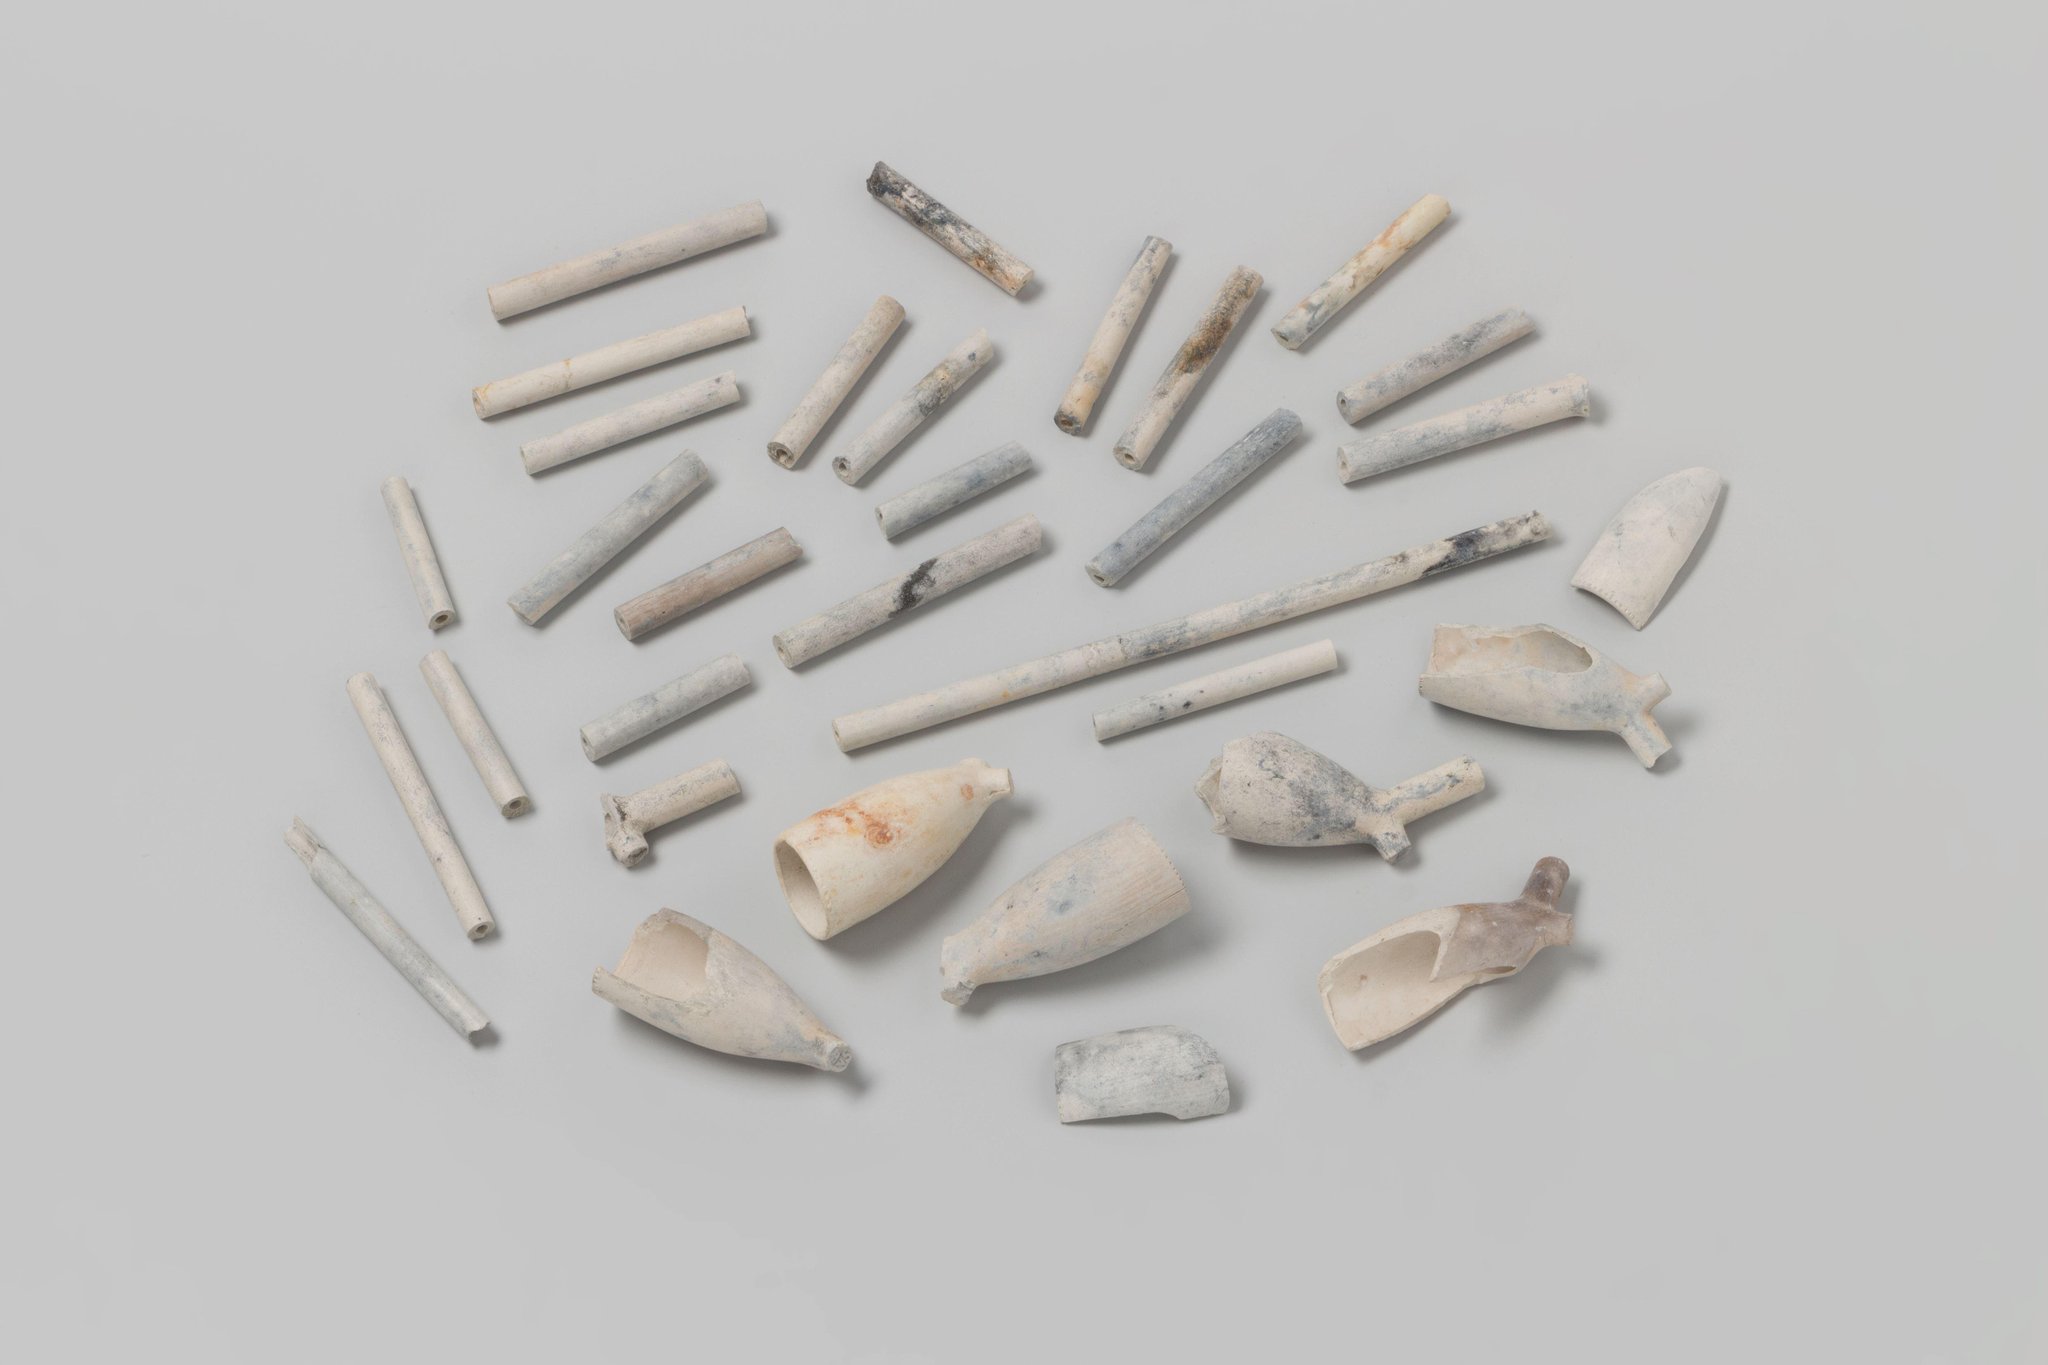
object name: pipe bowl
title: Fragmenten van pijpenkoppen en pijpenstelen uit het wrak van de Oost-Indiëvaarder 't Vliegend Hart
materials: clay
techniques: firing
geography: gouda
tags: 't vliegend hart (schip), verenigde oostindische compagnie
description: Zes gebroken koppen van aarden Goudse pijpen, hielmerk WS en éen (zonder steel) met als hielmerk een vijfbladige bloem of blad. Twee scherven van een kop. Vierentwintig stukken steel.